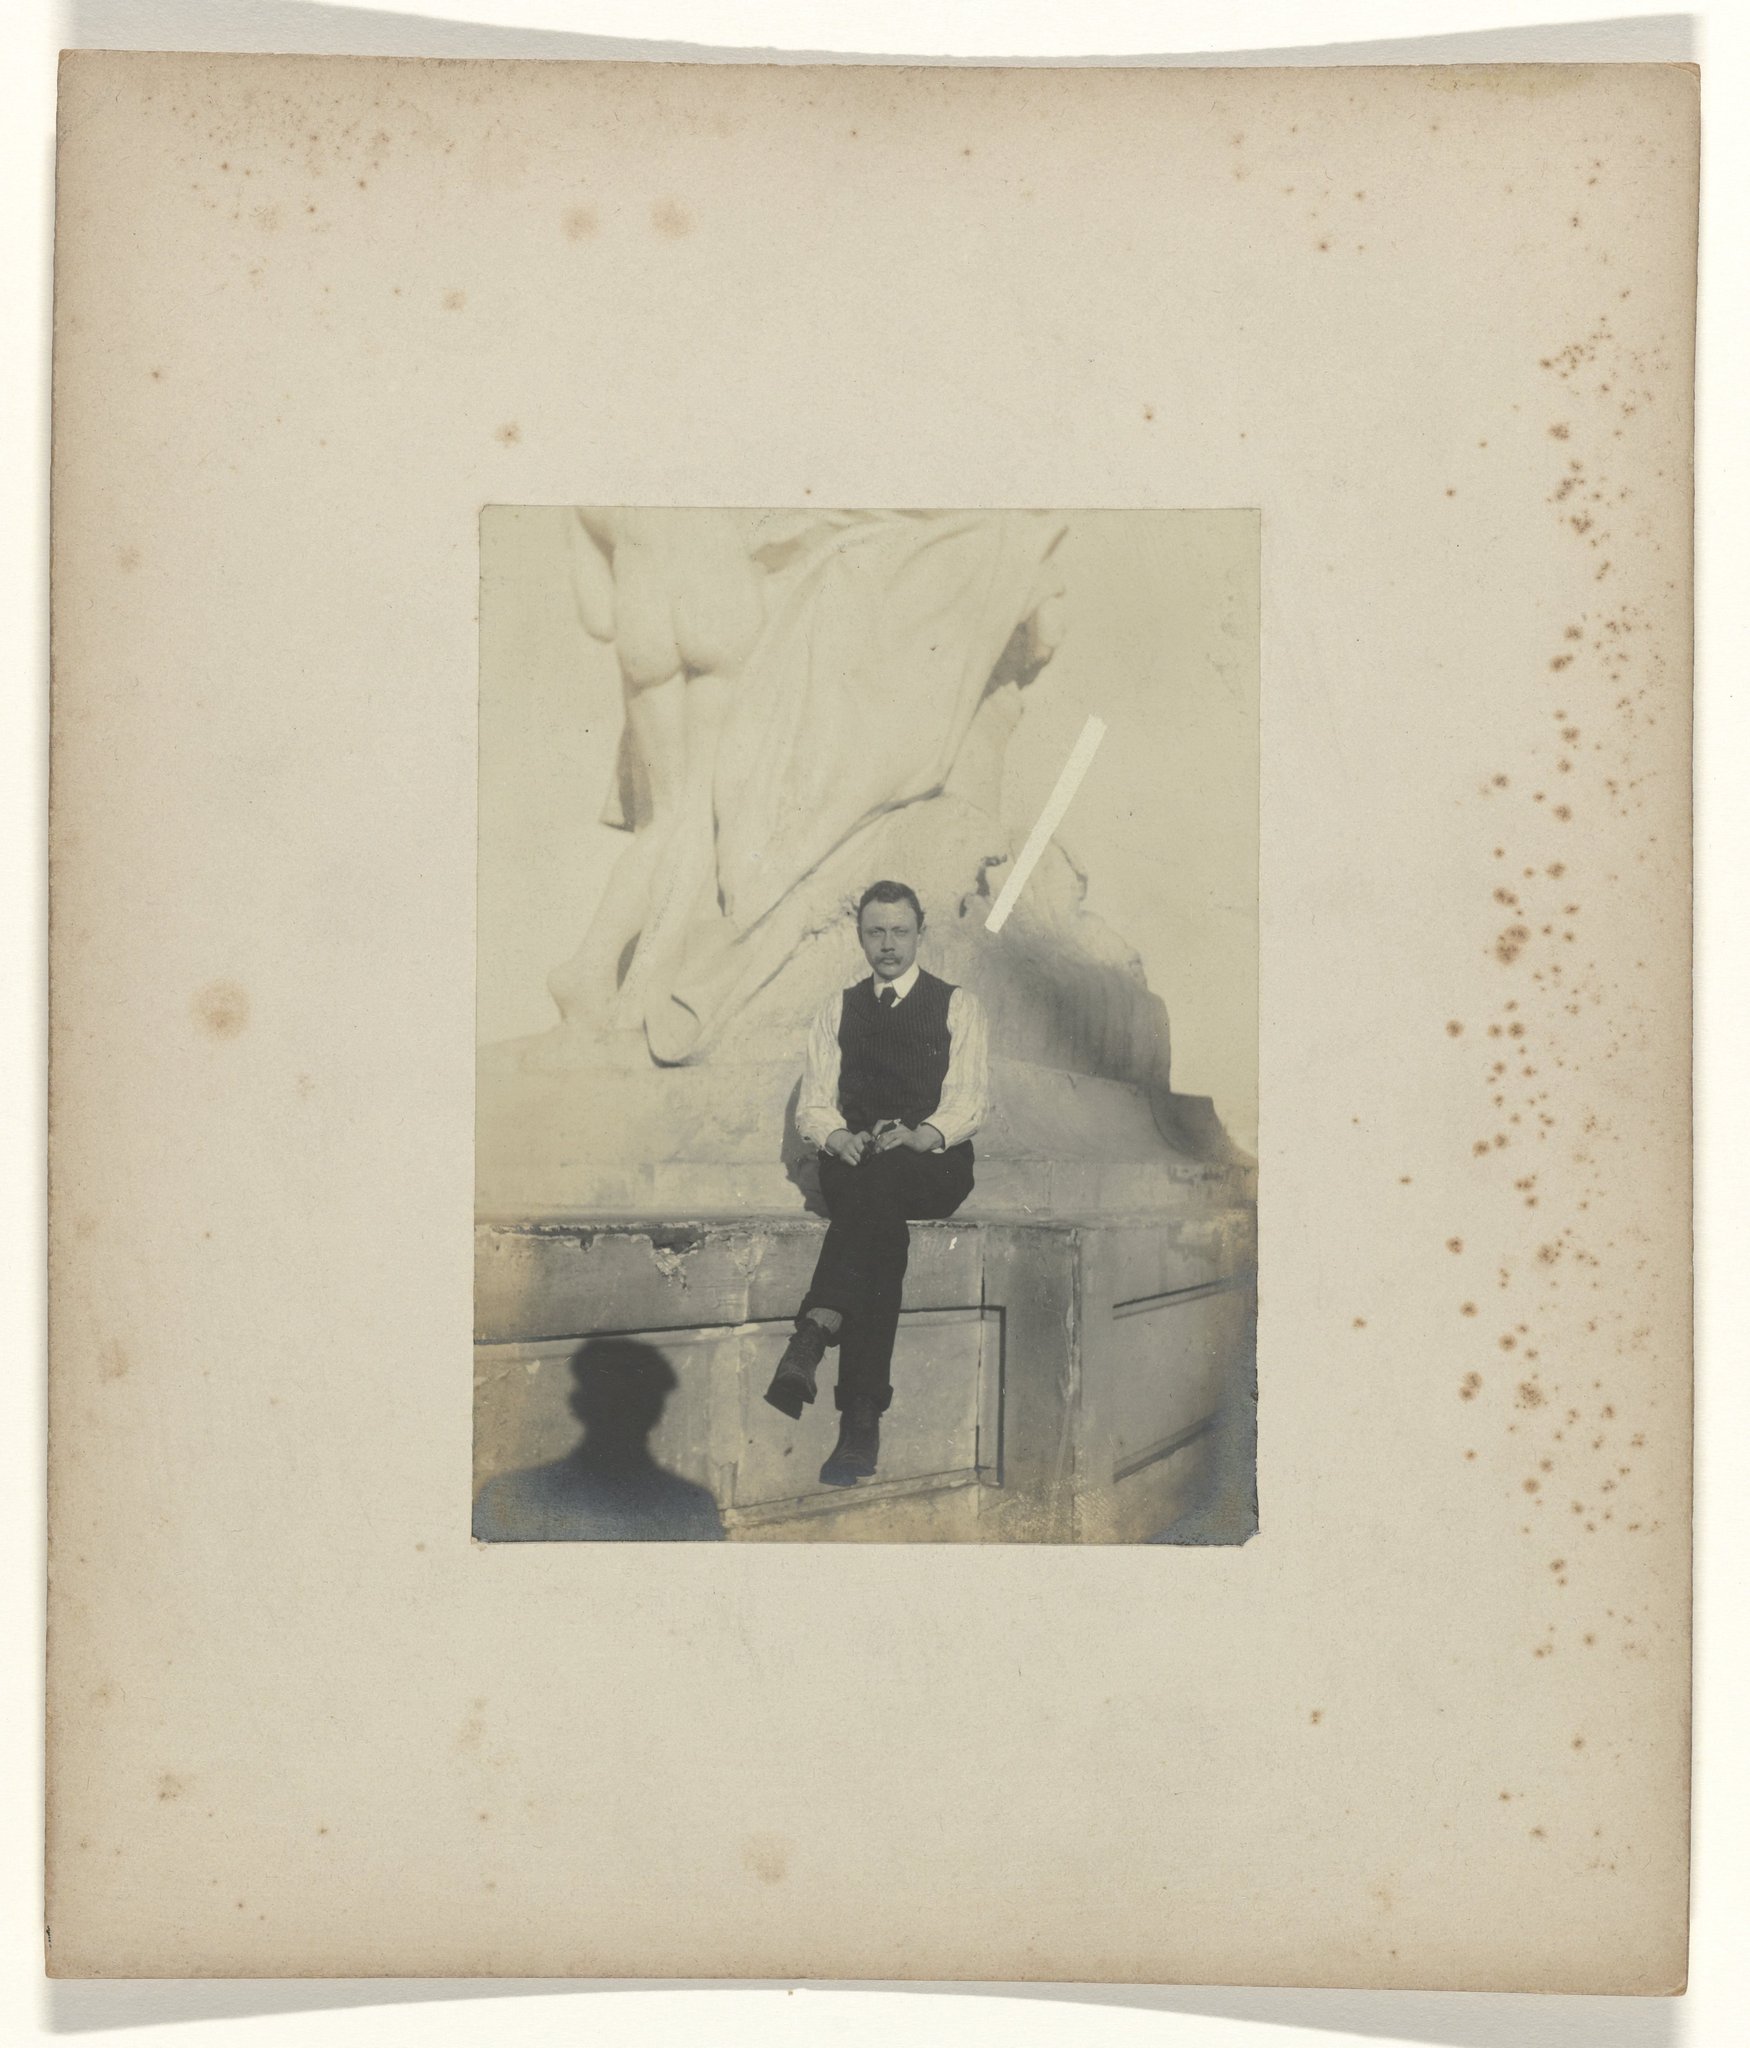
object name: photograph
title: Jan Catharinus Schüller zittend op de sokkel van een beeldhouwwerk op het terrein van de wereldtentoonstelling in St. Louis (Louisiana Purchase Exposition), 1904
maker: Anonymous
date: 1904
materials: cardboard, paper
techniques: gelatin silver print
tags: painter, print maker, draughtsman, jan schüller, world fair, world exhibition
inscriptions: annotation: ‘31 Dec ’04 // 70o in de zon’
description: Jan Catharinus Schüller zittend op de sokkel van een beeldhouwwerk op het terrein van de wereldtentoonstelling in St. Louis (Louisiana Purchase Exposition), 1904.